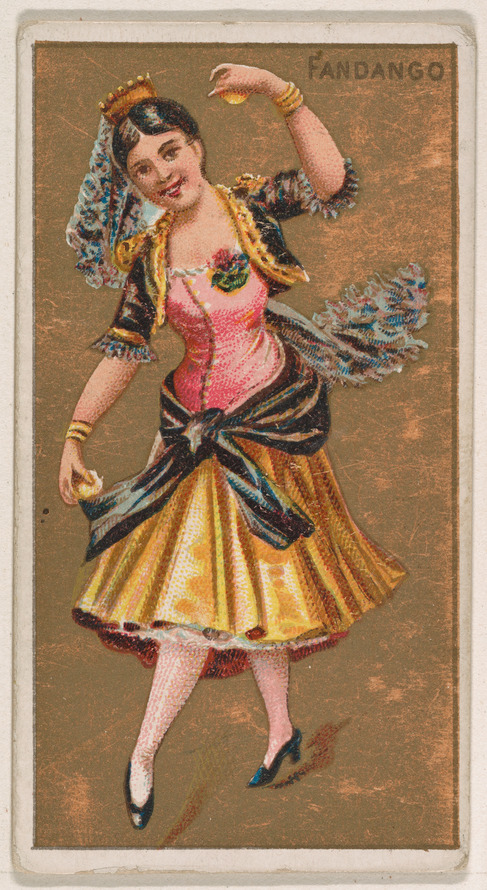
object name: print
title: Fandango, from National Dances (N225, Type 1) issued by Kinney Bros.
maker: kinney brothers tobacco company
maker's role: publisher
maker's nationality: american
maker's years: 1869-2011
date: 1889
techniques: color lithograph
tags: dance,women,dancers